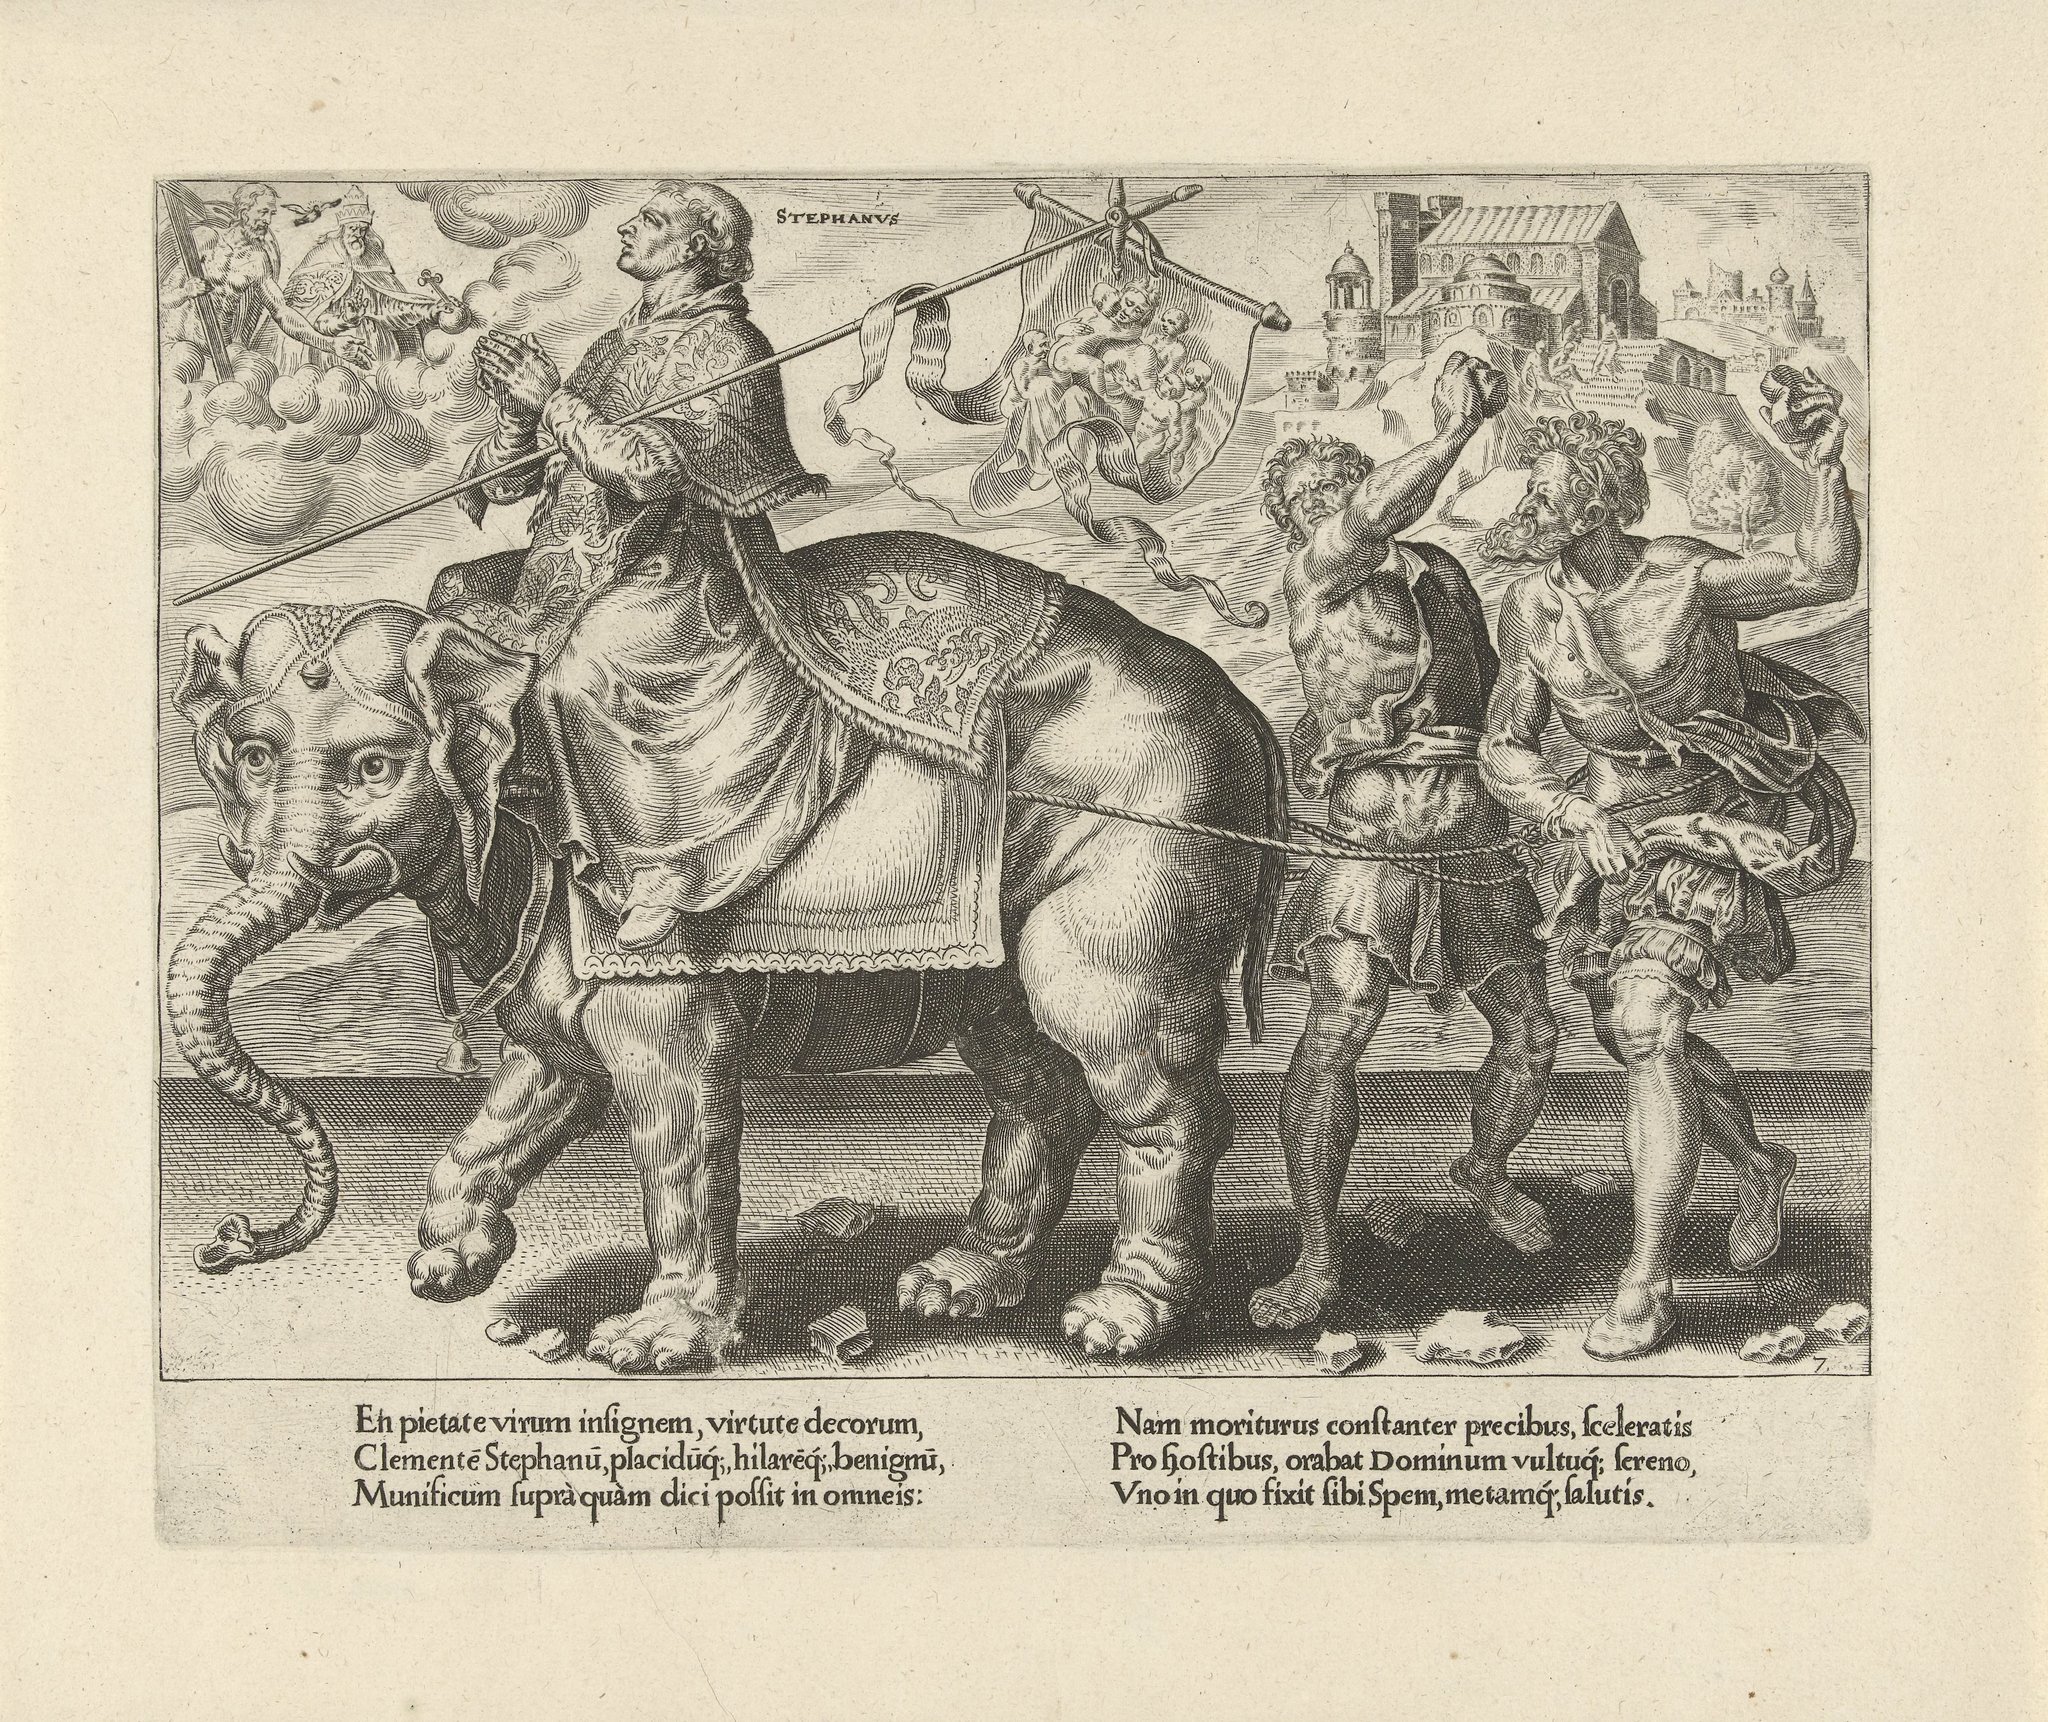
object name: print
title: Patientiae Trivmphvs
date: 1559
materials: paper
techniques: engraving, etching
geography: haarlem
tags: the stoning of stephen; the witnesses lay down their clothes at saul's feet, the deacon and (proto)martyr stephen; possible attributes: censer, stones, triumphs (allegorical and symbolic), trunked animals: elephant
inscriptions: collector's mark: Lugt 2228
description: Op de voorgrond de heilige Stefanus, rijdend op een olifant. Hij bidt tot God in de hemel. In zijn handen een kruis met een vaandel. Op het vaandel de personificatie van Barmhartigheid. Achter Stefanus twee mannen die hem stenigen. Op de achtergrond de tempel van Jeruzalem. De prent heeft een Latijns onderschrift van zes regels en maakt deel uit van een achtdelige serie over de triomf van de Lijdzaamheid.